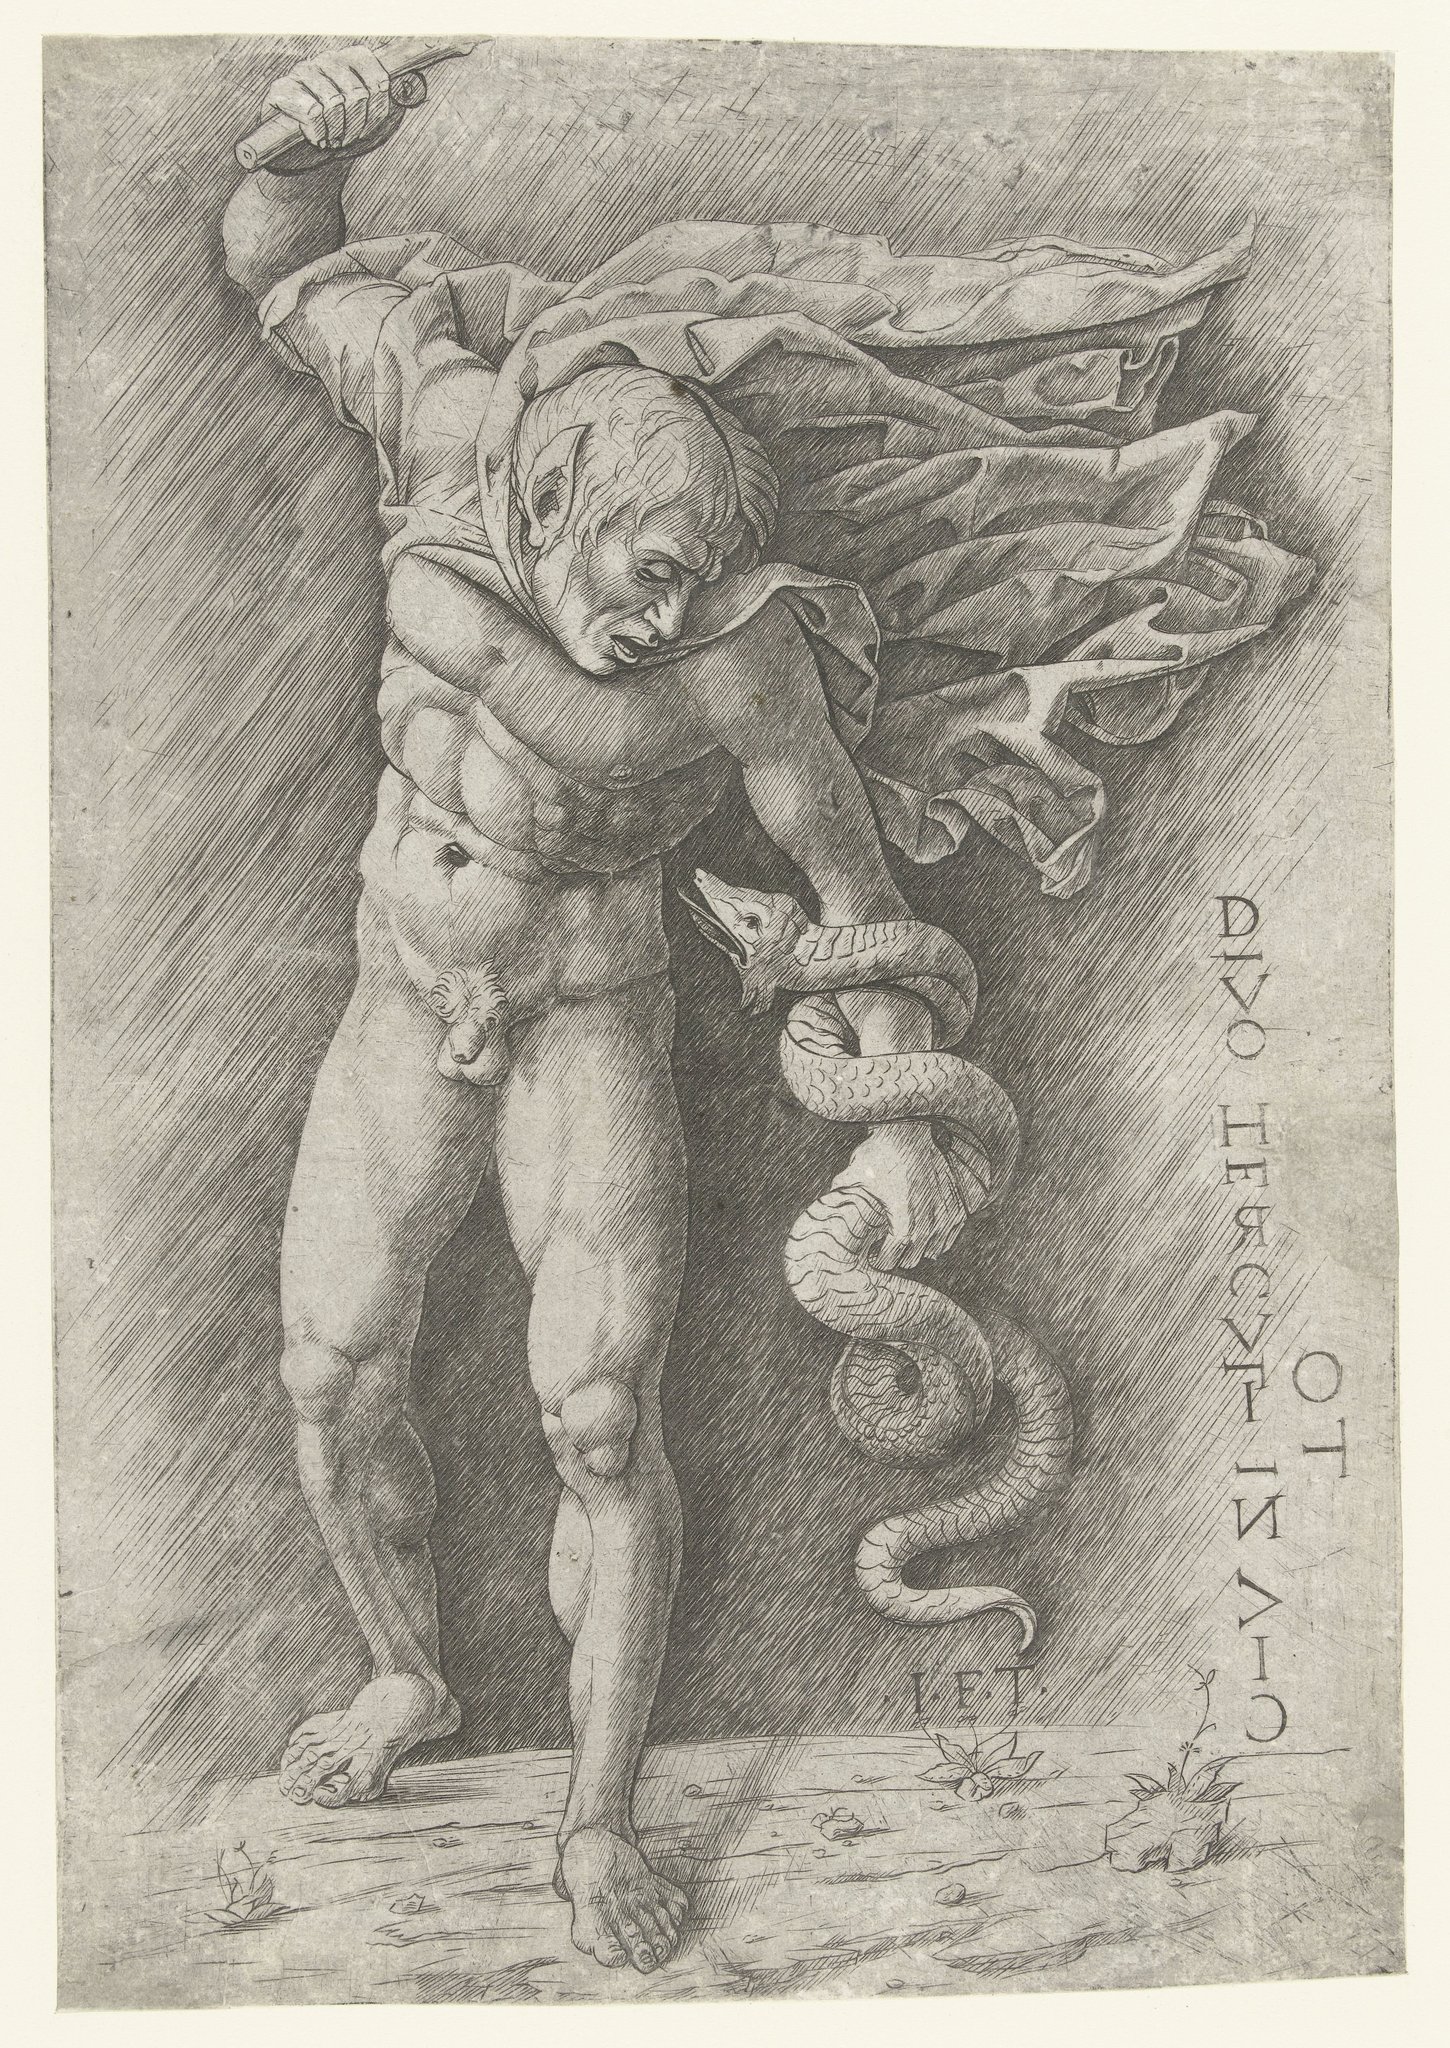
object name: print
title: Faun Fighting a Snake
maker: Anonymous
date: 1500-1550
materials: paper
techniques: engraving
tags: snakes, satyr(s) (in general)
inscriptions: collector's mark: Lugt 240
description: Although the inscription indicates ‘Hercules’, the pointed ears of the figure reveal him to be a faun (forest god). The engraving is based on a drawing by Andrea Mantegna in the British Museum collection, in London. Besides following the master’s design, the anonymous engraver also emulated his robust style of drawing with thick, closely placed parallel lines.